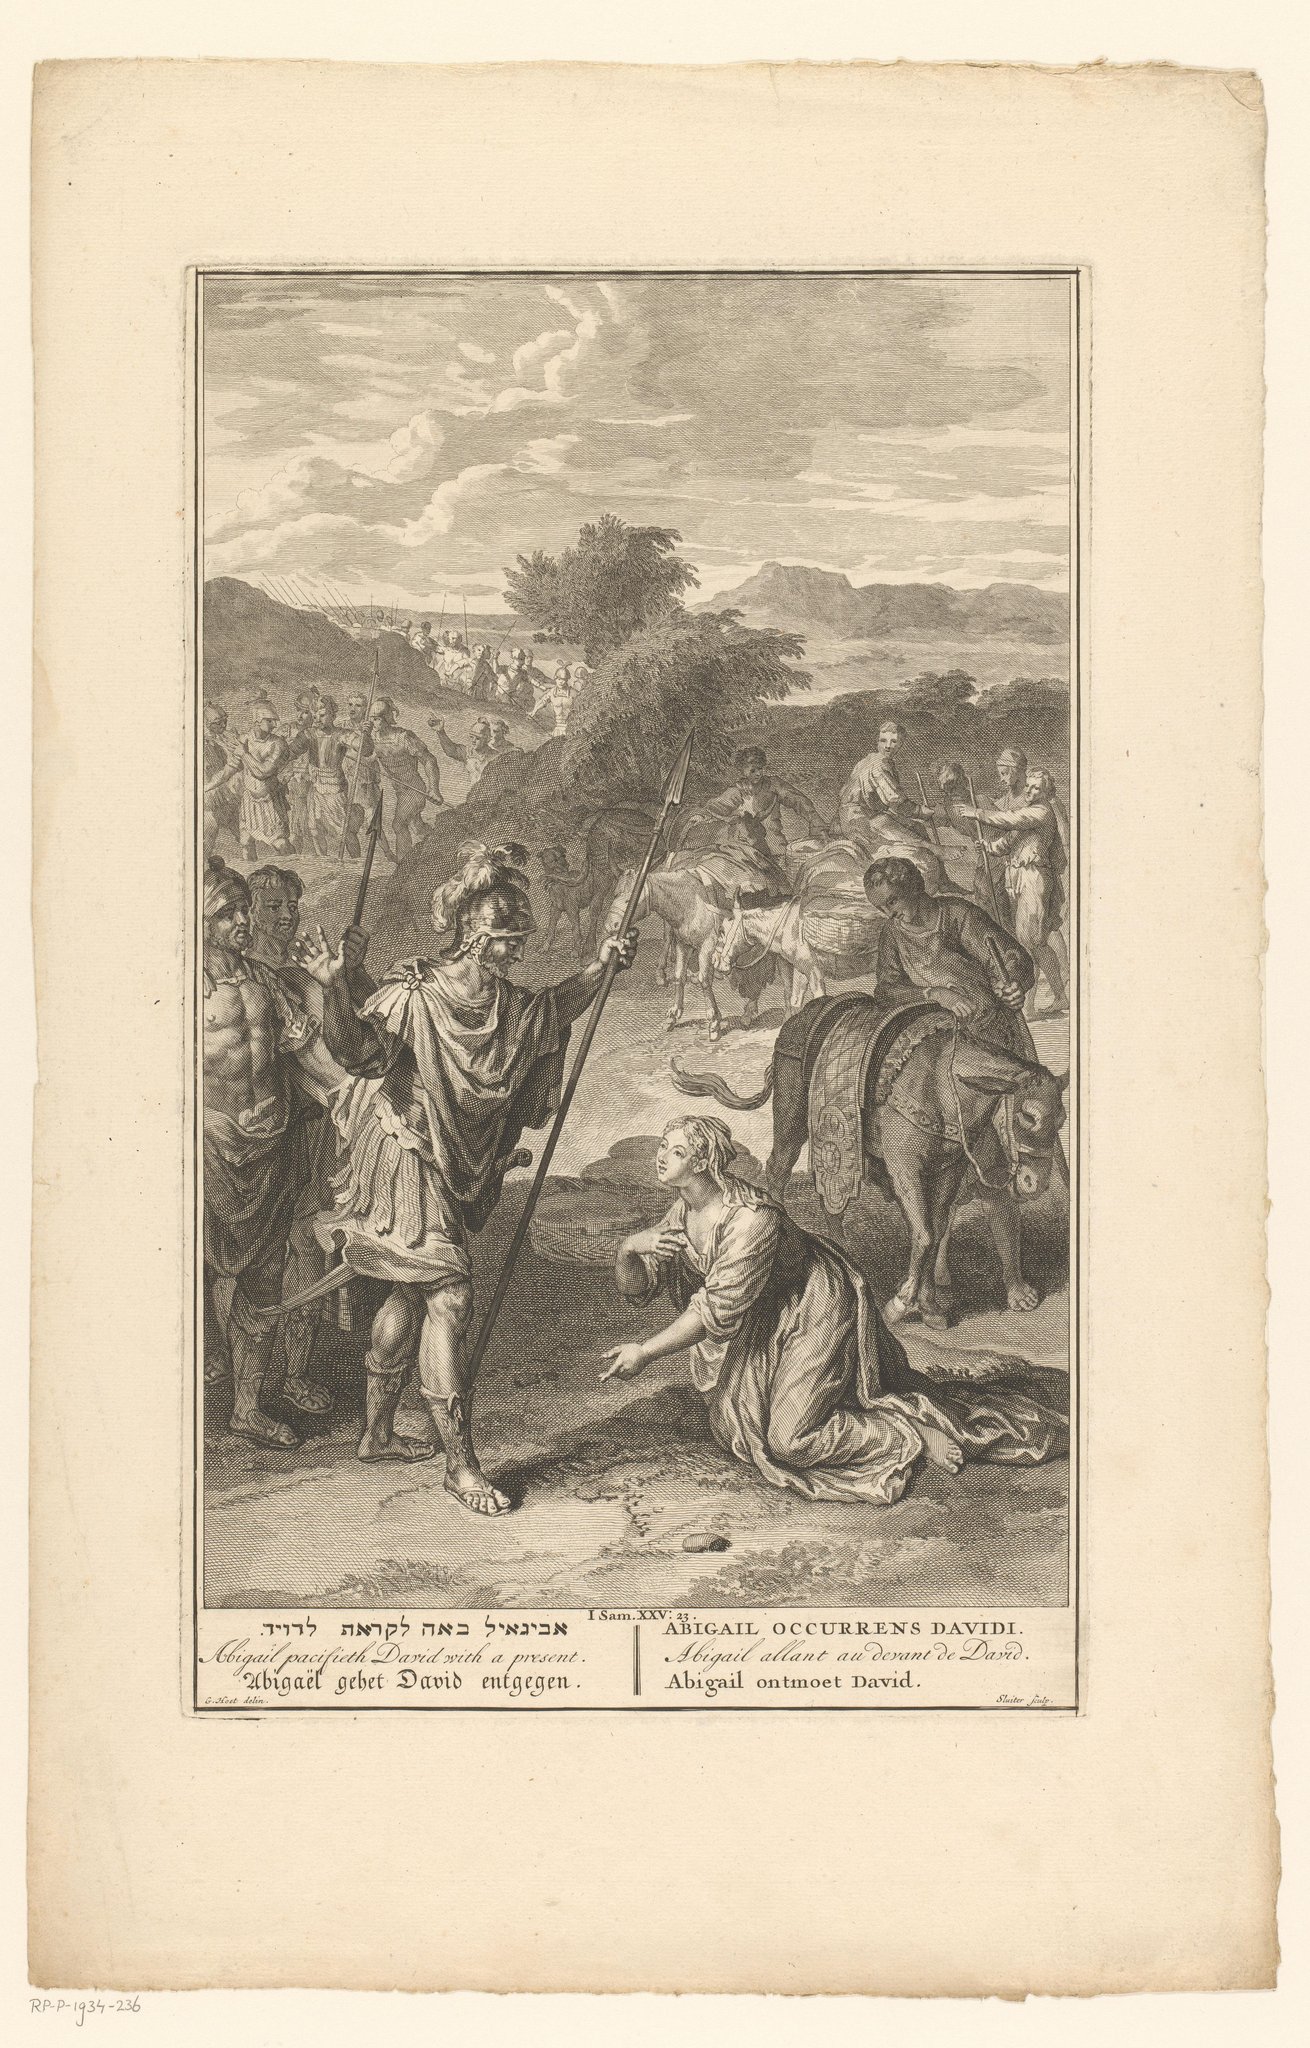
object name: print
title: Abigail ontmoet David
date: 1705-1720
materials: paper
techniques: engraving, etching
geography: amsterdam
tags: meeting of david and abigail, who kneels before him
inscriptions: collector's mark: Lugt 2228, collector's mark: ‘Utrechts Fundatie huijs’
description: David geeft met zijn hand een stopteken aan de stoet soldaten achter hem, wanneer hij Abigail voor hem ziet knielen. Achter haar staat een dienaar met een ezel, met op de achtergrond de rest van haar dienaren met volgepakte ezels. Illustratie van de Bijbeltekst 1 Sam. 25:23. Onder de voorstelling de titel in het Hebreeuws, Engels, Duits, Latijn, Frans en Nederlands.